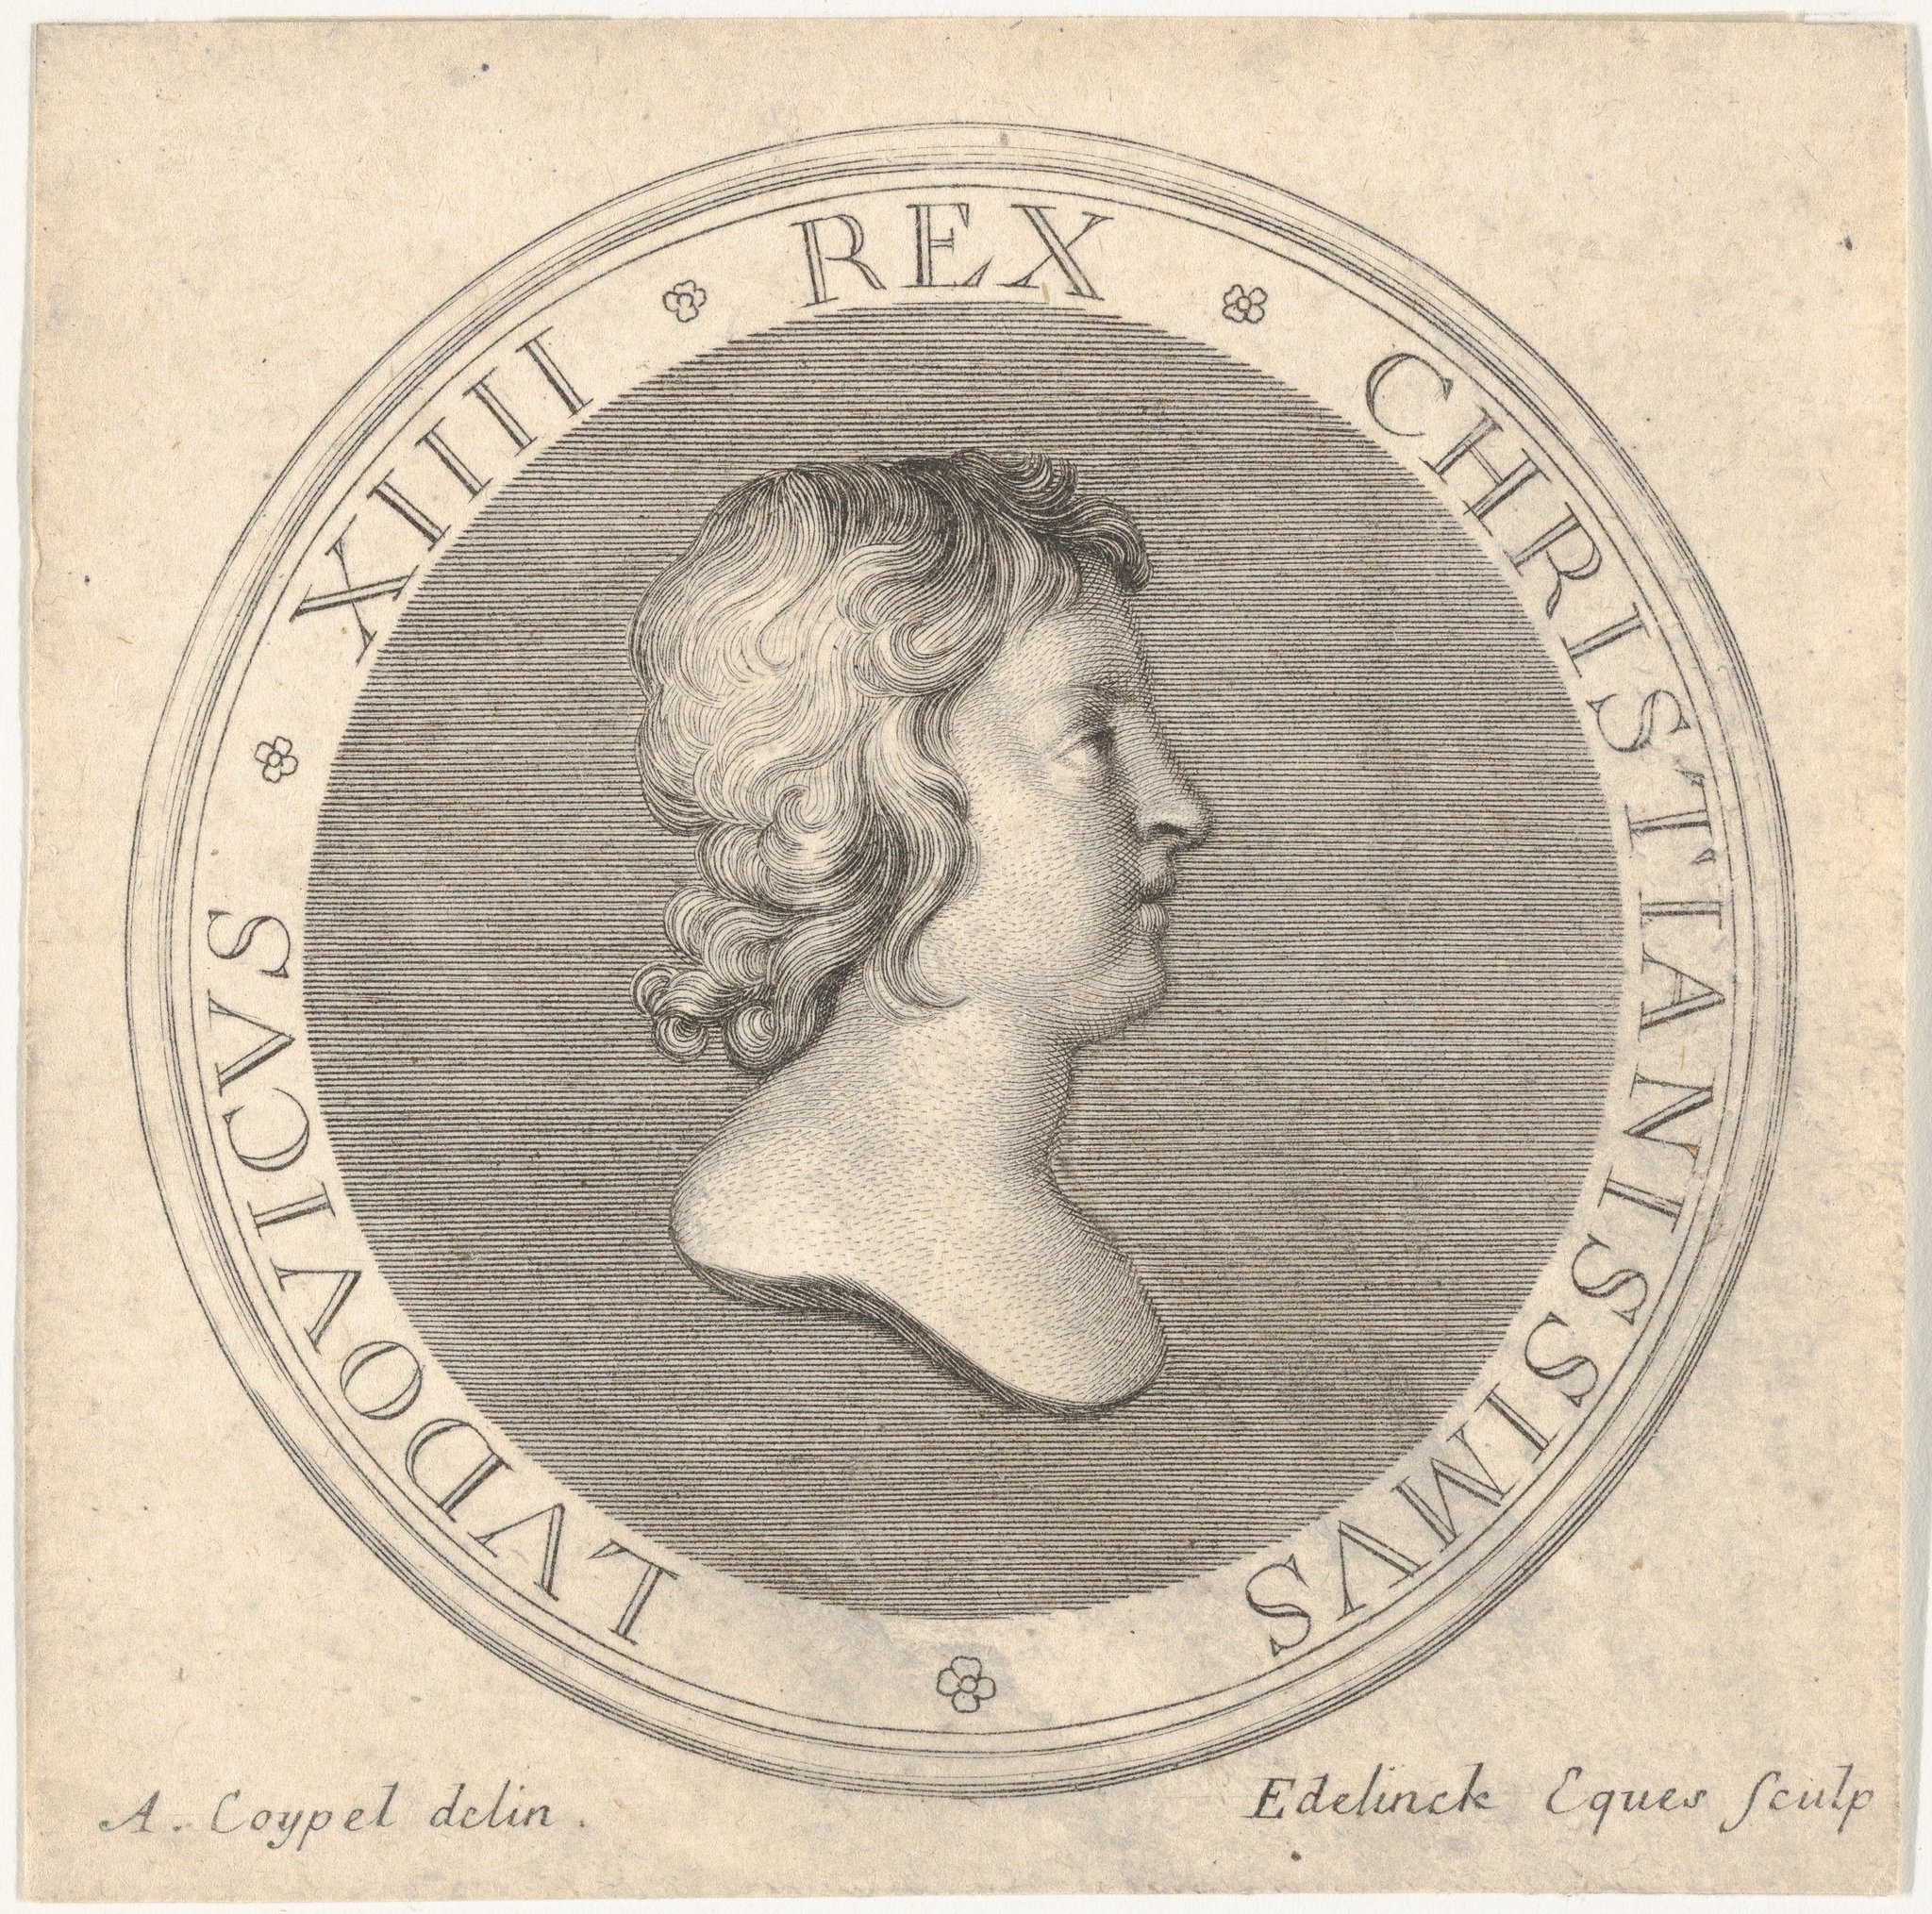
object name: print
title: Medal of Louis XIV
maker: gerard edelinck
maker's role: artist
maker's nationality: dutch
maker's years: 1640-1707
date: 1601-1800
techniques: engraving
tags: louis xiv,profiles